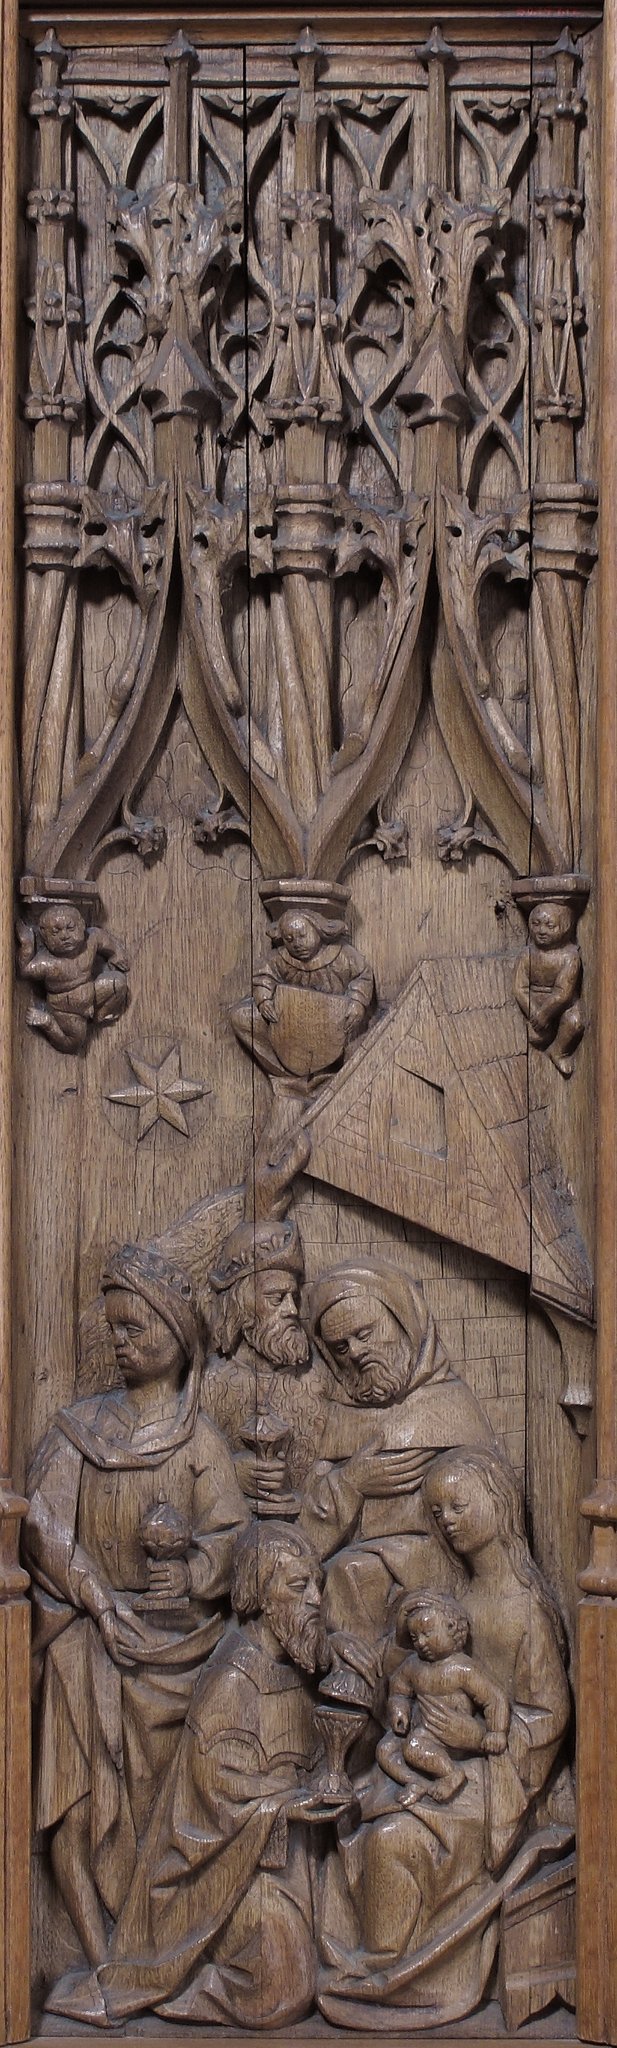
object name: panel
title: Panel with the Adoration of the Magi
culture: french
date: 1501-1533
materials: wood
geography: france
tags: men,madonna and child,adoration of the magi,saints